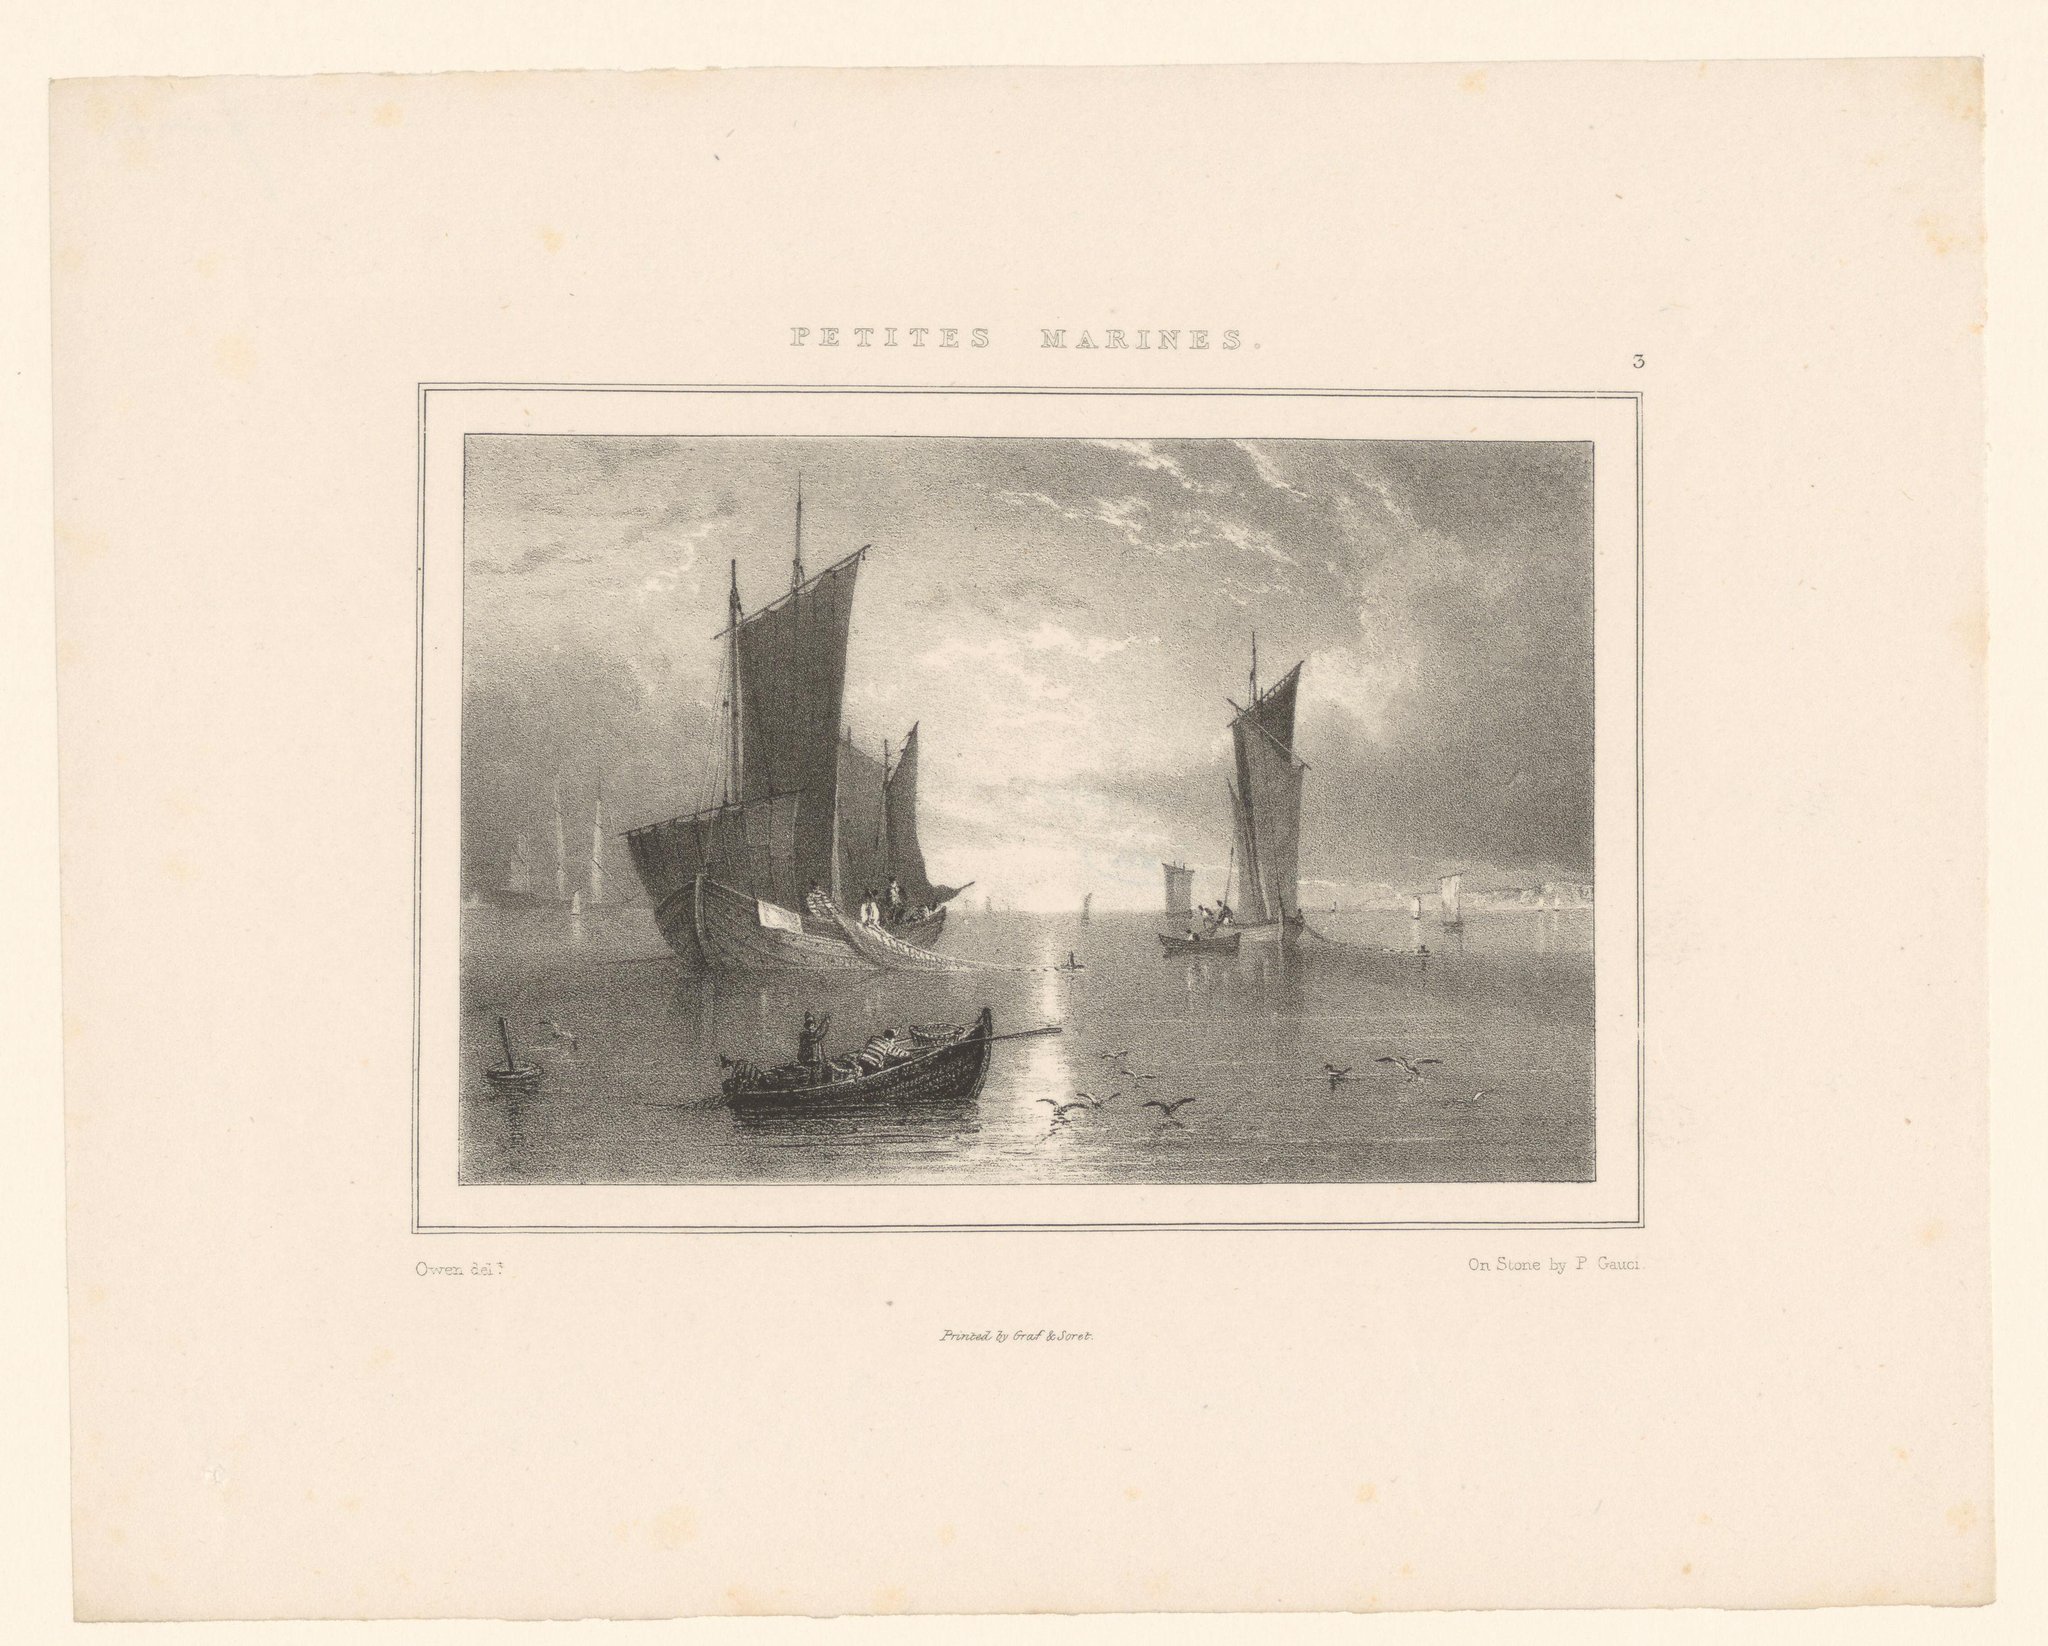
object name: print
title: Boten op zee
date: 1834-1866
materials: paper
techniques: lithograph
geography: london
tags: sailing-ship, sailing-boat, sea (seascape)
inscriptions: collector's mark: Lugt 2228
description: Prent behoort waarschijnlijk tot de serie 'Petites marines'.